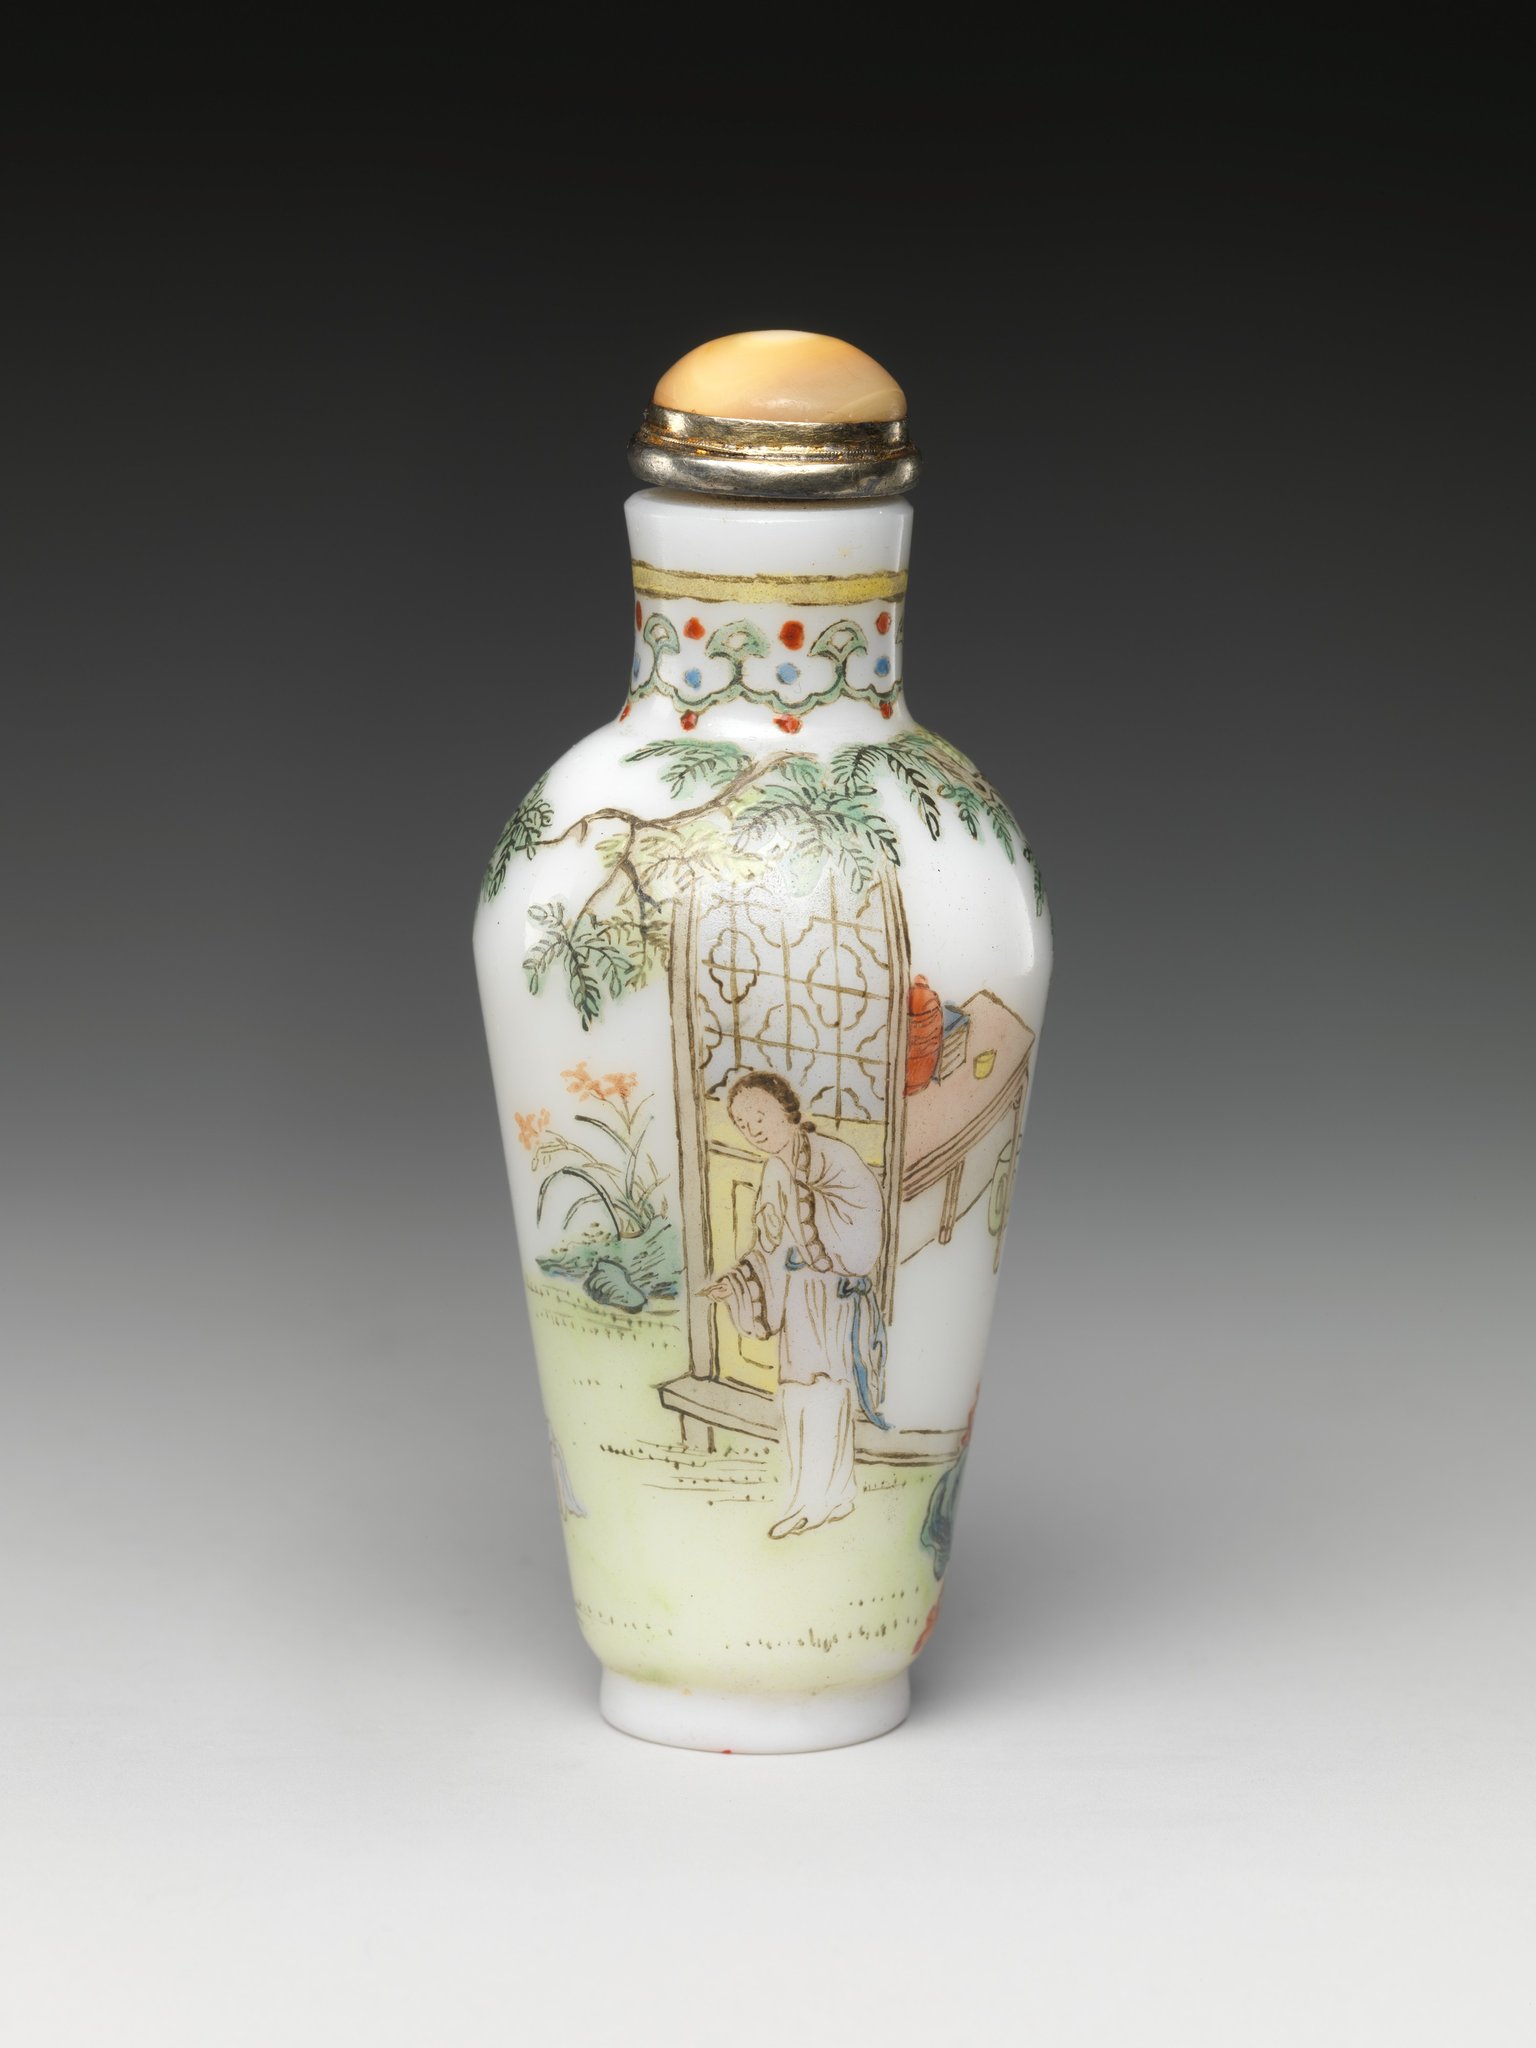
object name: snuff bottle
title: Snuff Bottle with Figures in a Garden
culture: chinese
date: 1736-1795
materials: enamel, glass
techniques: painting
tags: human figures